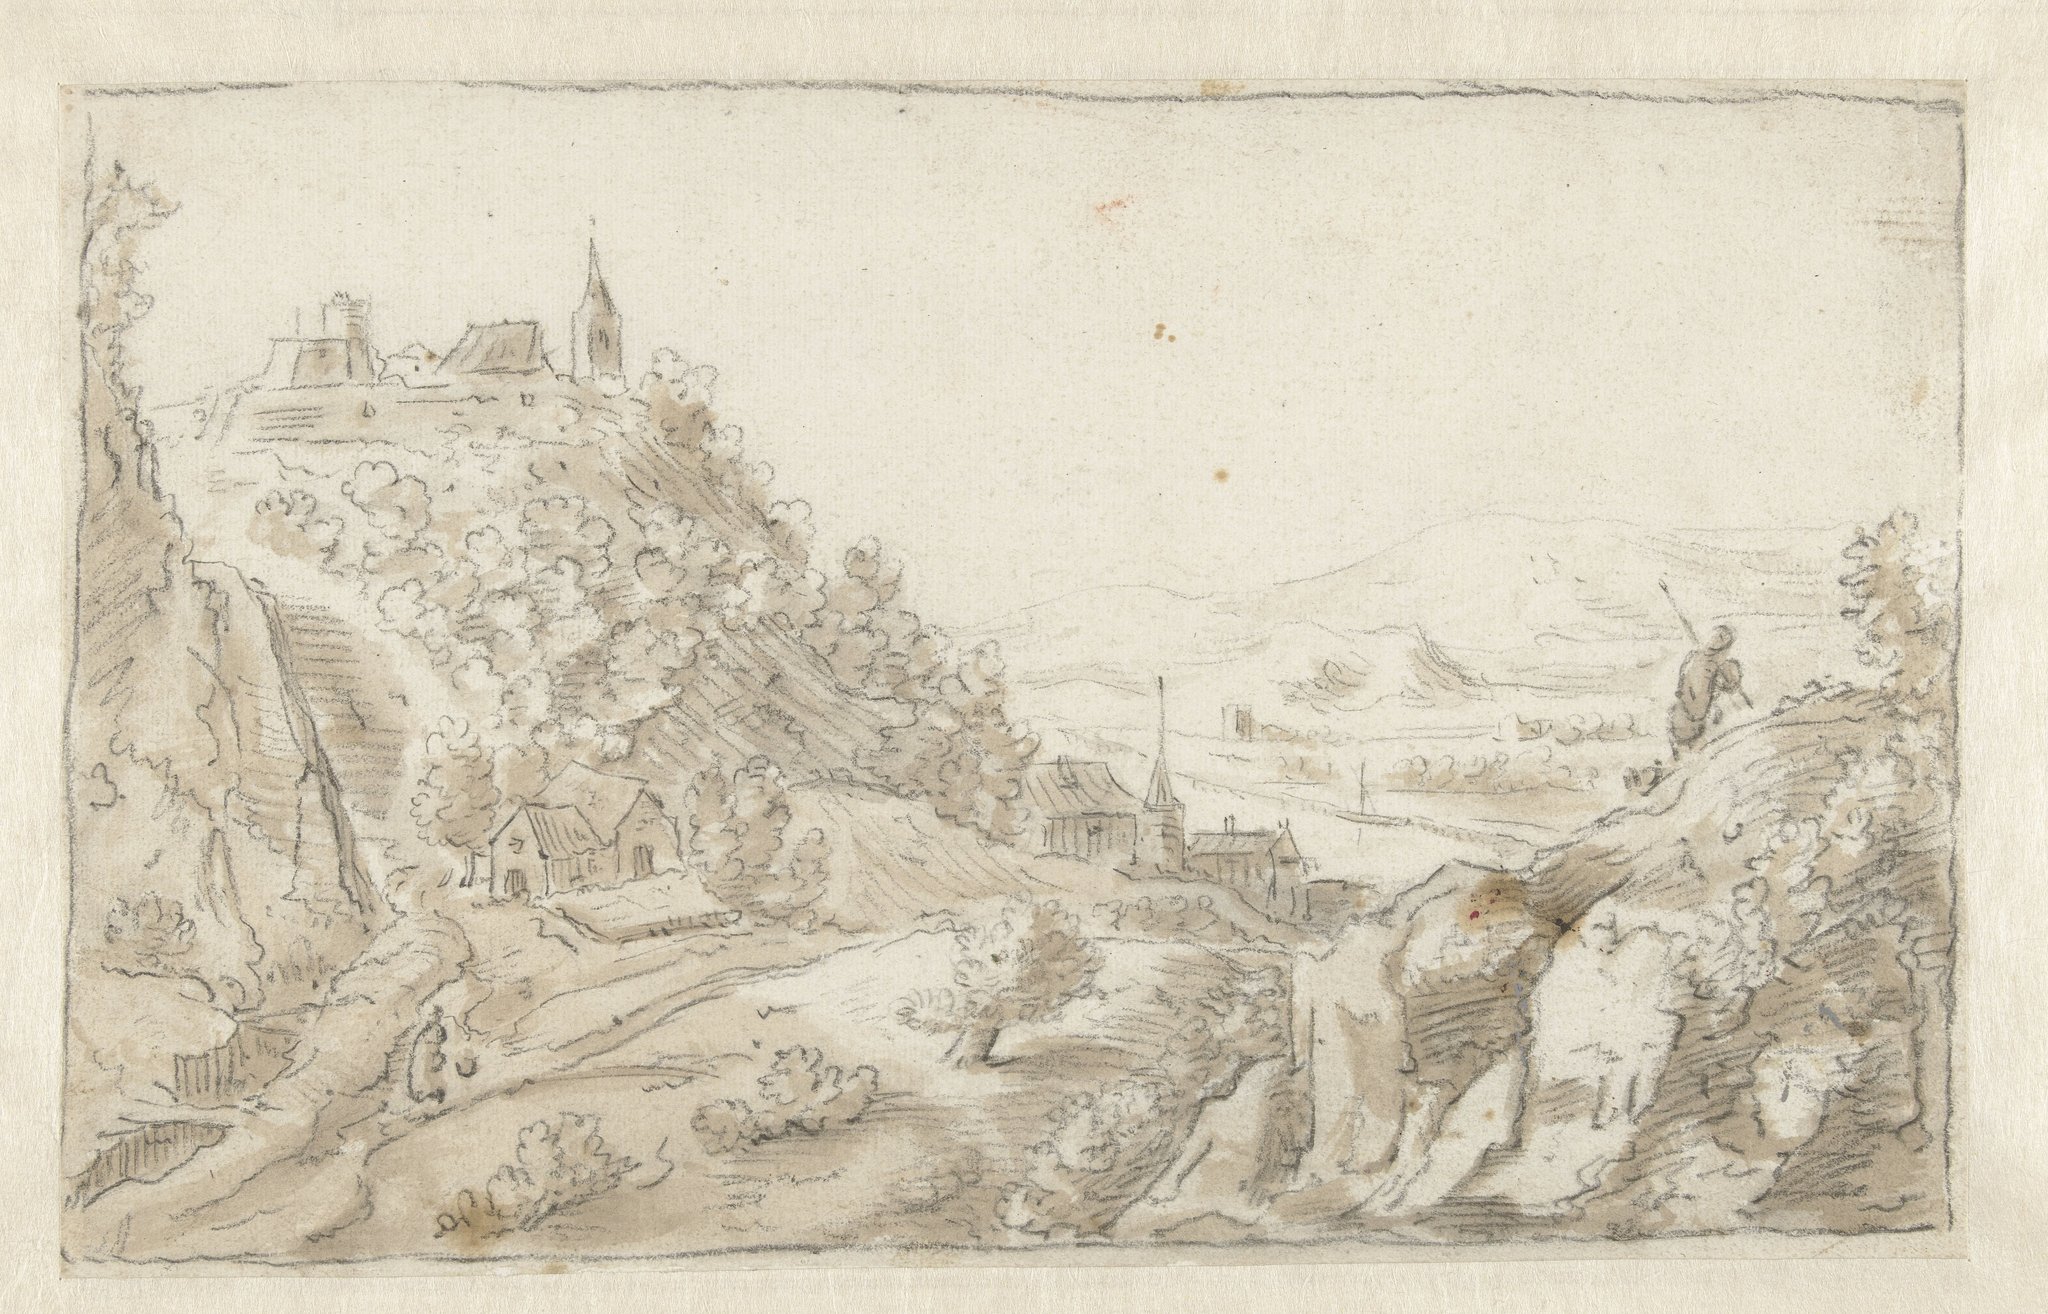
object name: drawing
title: Berglandschap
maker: herman saftleven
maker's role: draughtsman, painter, print maker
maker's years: 1609-1685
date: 1619-1685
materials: chalk, paper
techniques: brush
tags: low hill country